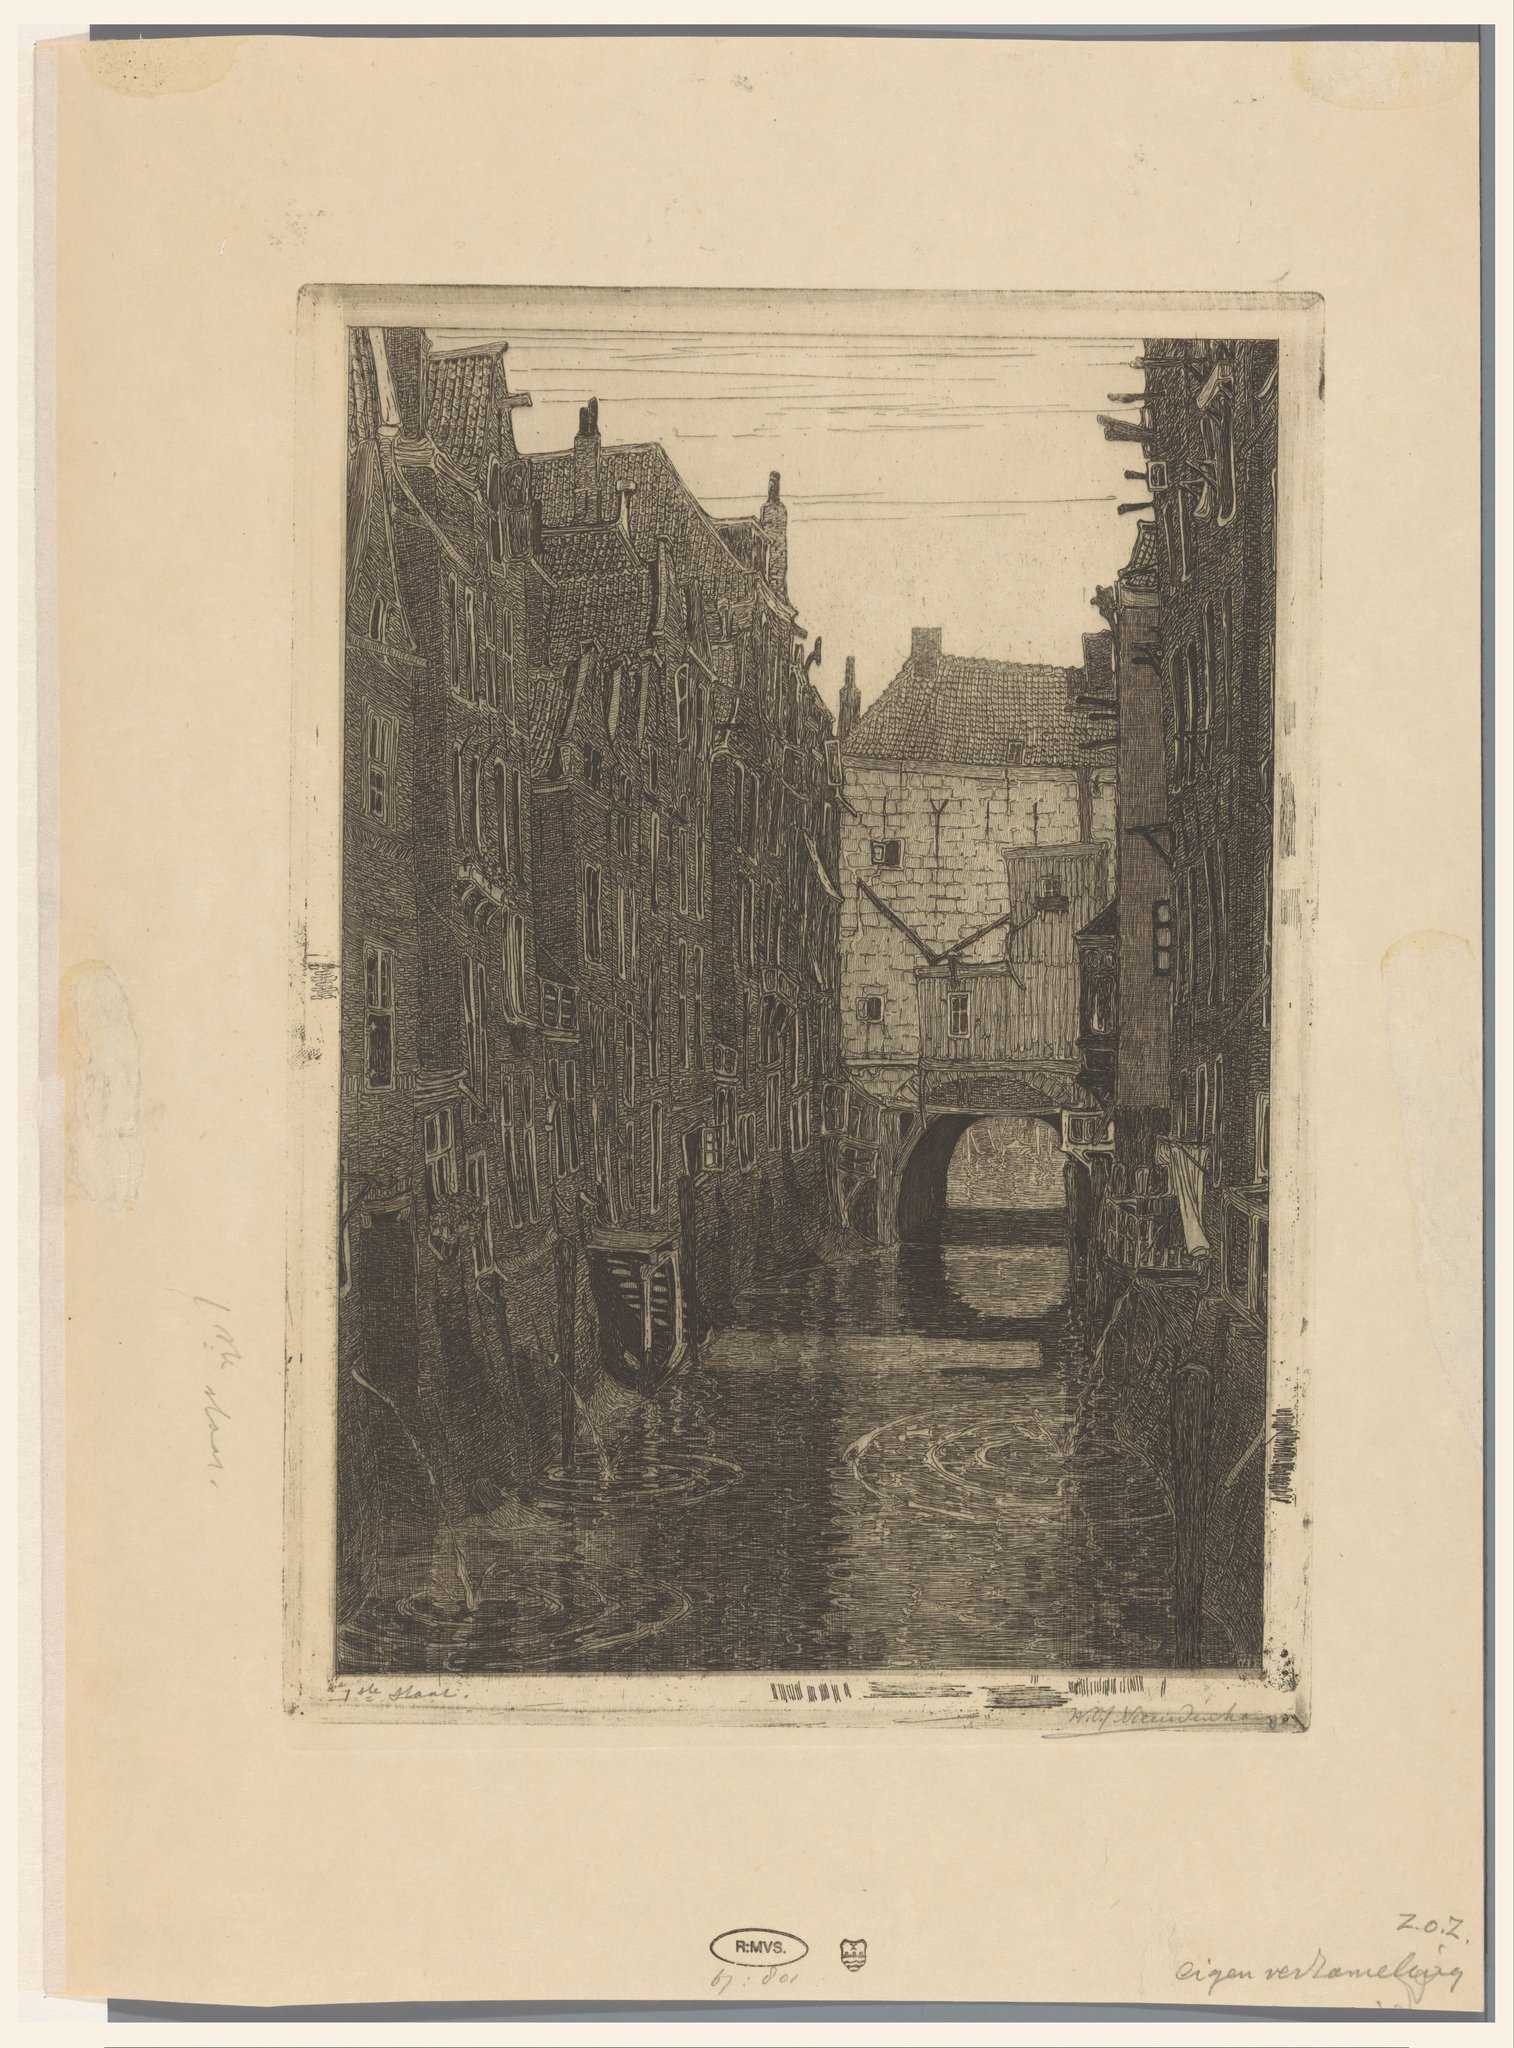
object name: print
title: Huizen aan de Voorstraatshaven in Dordrecht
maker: wijnand otto jan nieuwenkamp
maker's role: draughtsman, print maker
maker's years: 1874-1950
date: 1897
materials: paper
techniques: etching, intaglio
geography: amsterdam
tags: canals, waters (in city)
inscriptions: collector's mark: Lugt 2228, collector's mark: Lugt 2760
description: Op de achtergrond de achtergevel van het stadhuis van Dordrecht.